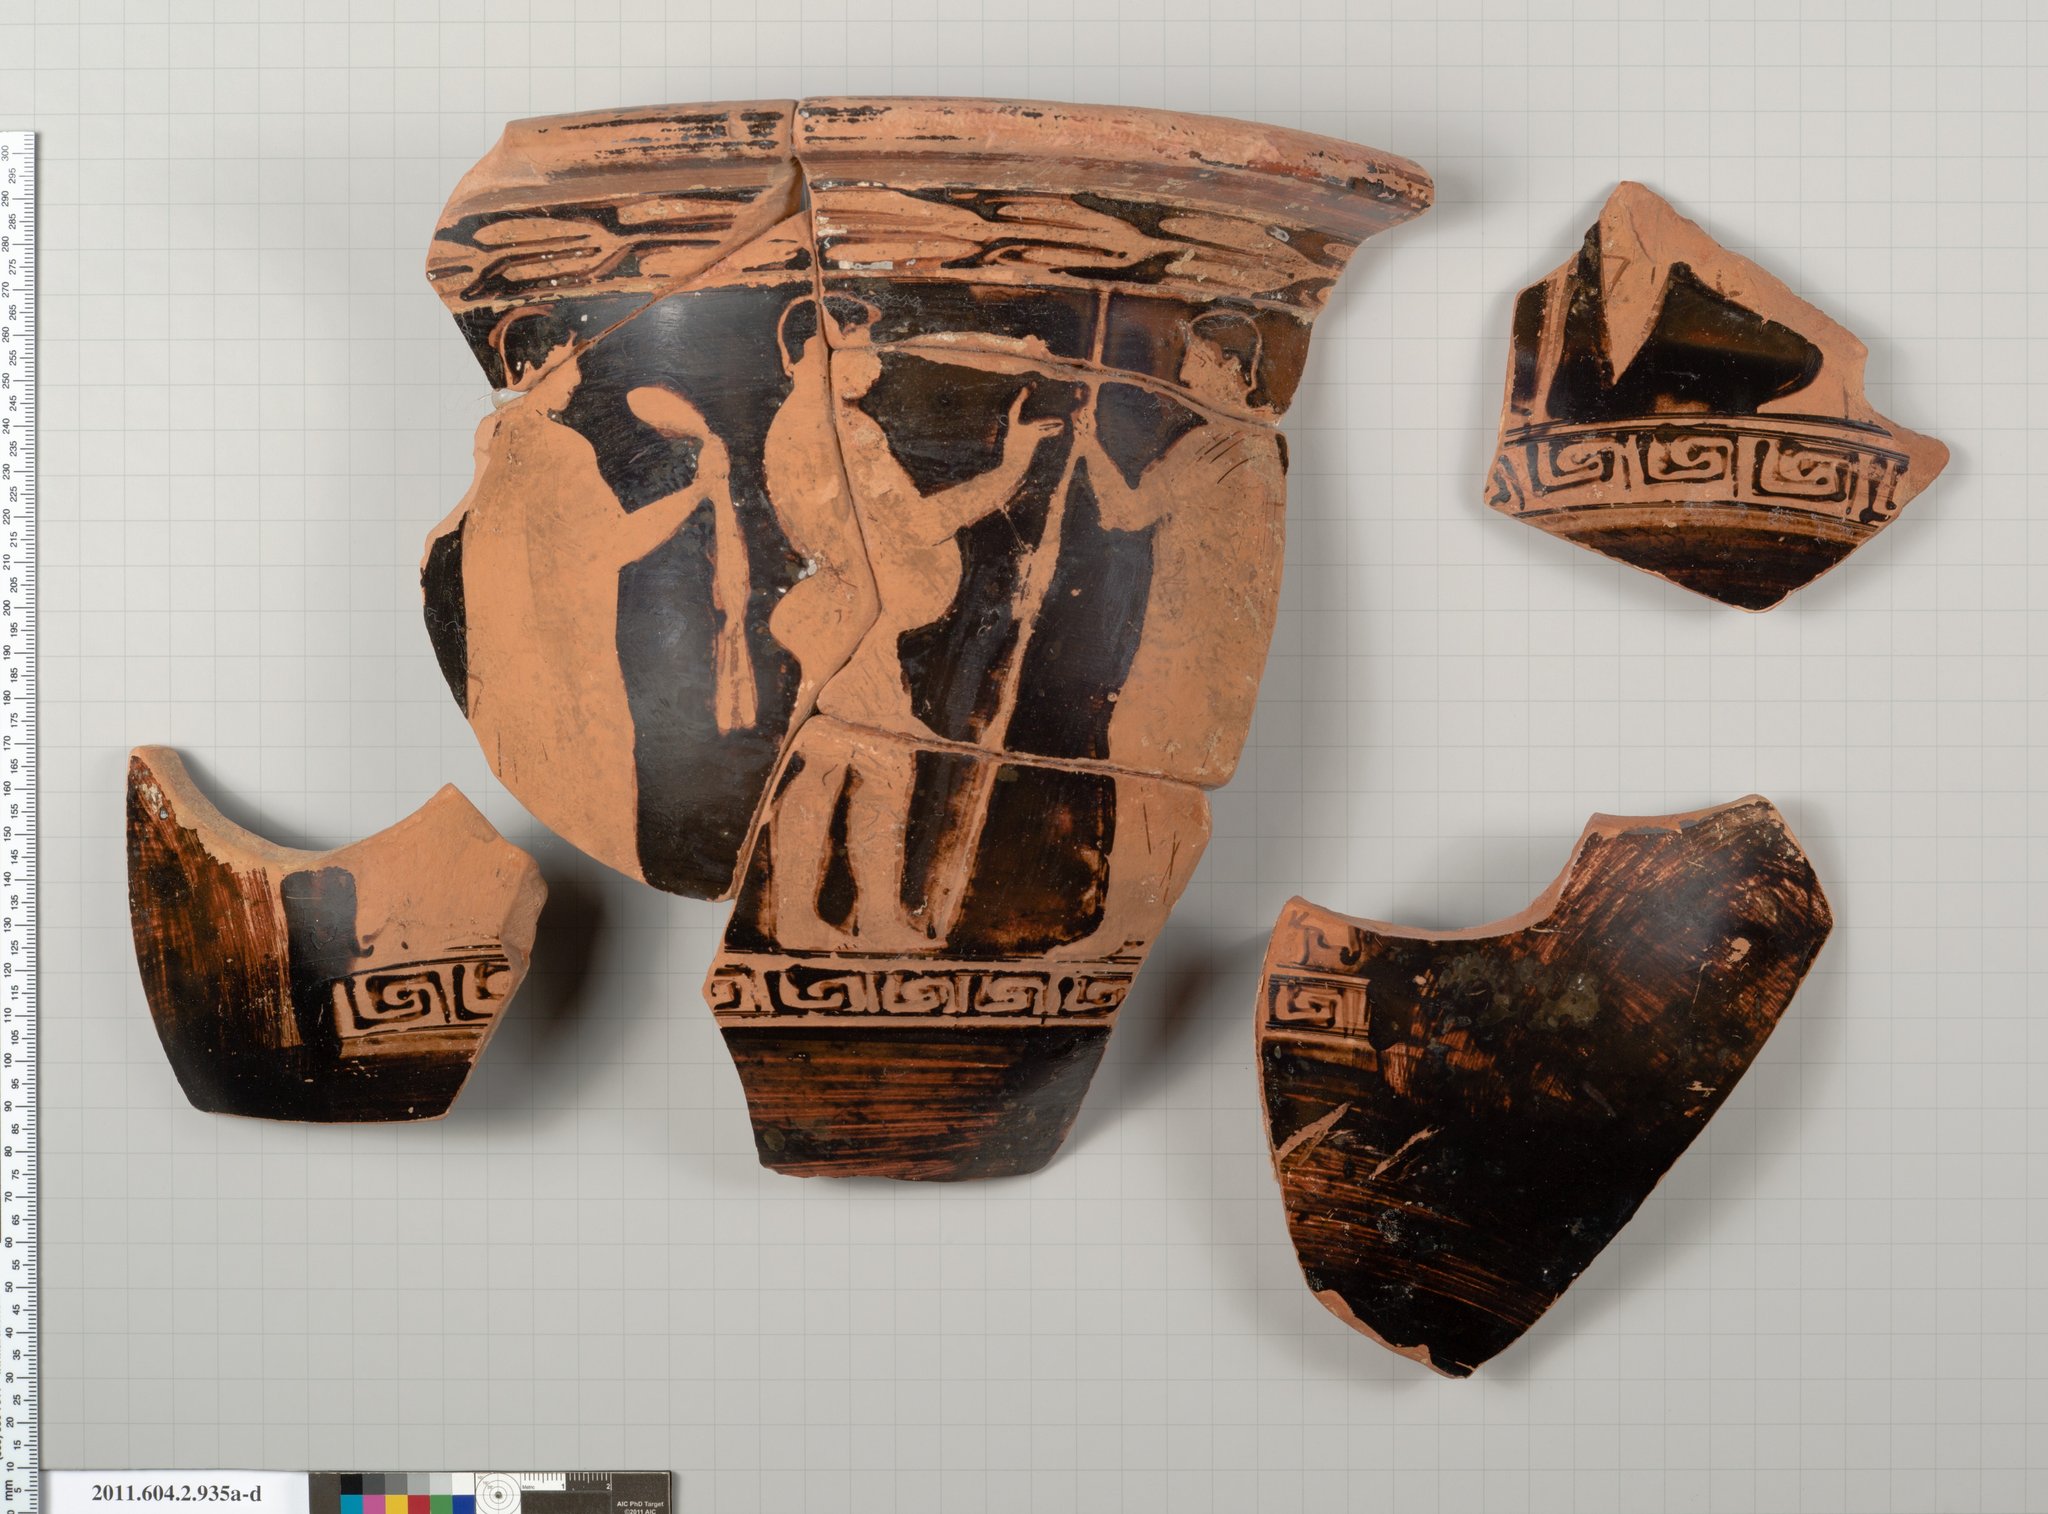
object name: bell krater fragment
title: Terracotta fragments of a bell-krater (bowl for mixing wine and water)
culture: greek, attic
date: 430 BCE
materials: terracotta